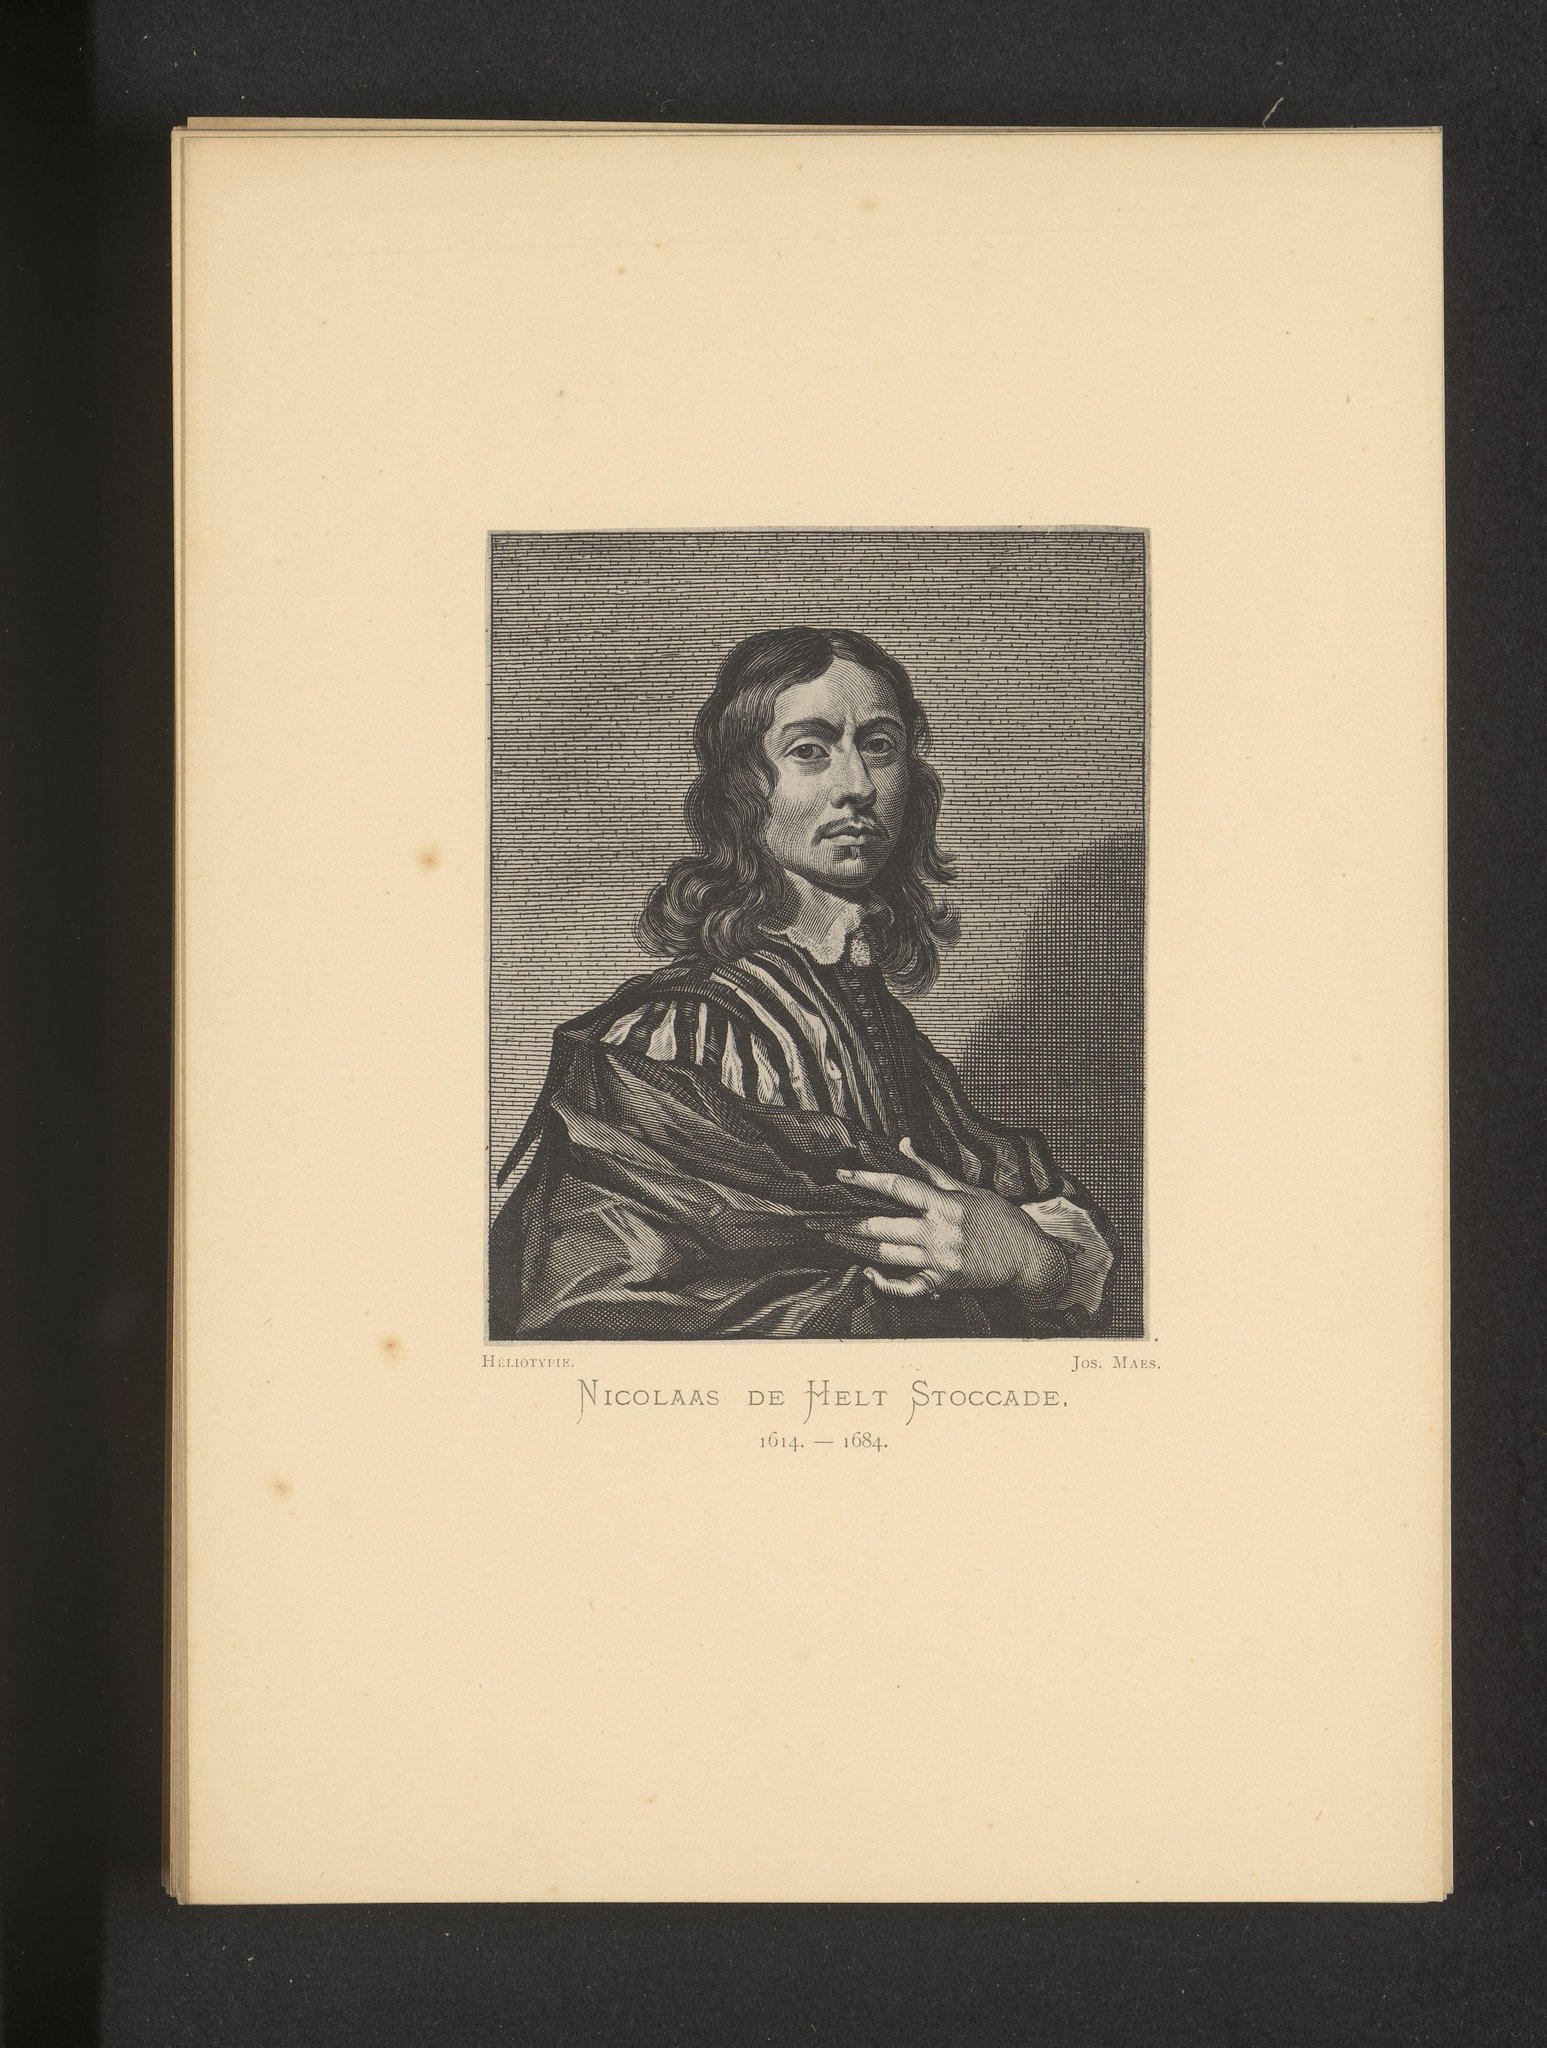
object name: photomechanical print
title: Nicolaas de Helt Stoccade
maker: joseph maes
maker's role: fotograaf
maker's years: 1838-1908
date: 1872-1877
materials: cardboard, paper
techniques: photograph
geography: antwerp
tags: nijmegen, amsterdam, painter, nicolaes van helt stockade, historical persons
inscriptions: inscription: ‘1614. - 1684.’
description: Deze prent maakt deel uit van een omslag met 150 prenten en een katern met een lijst van afbeeldingen.